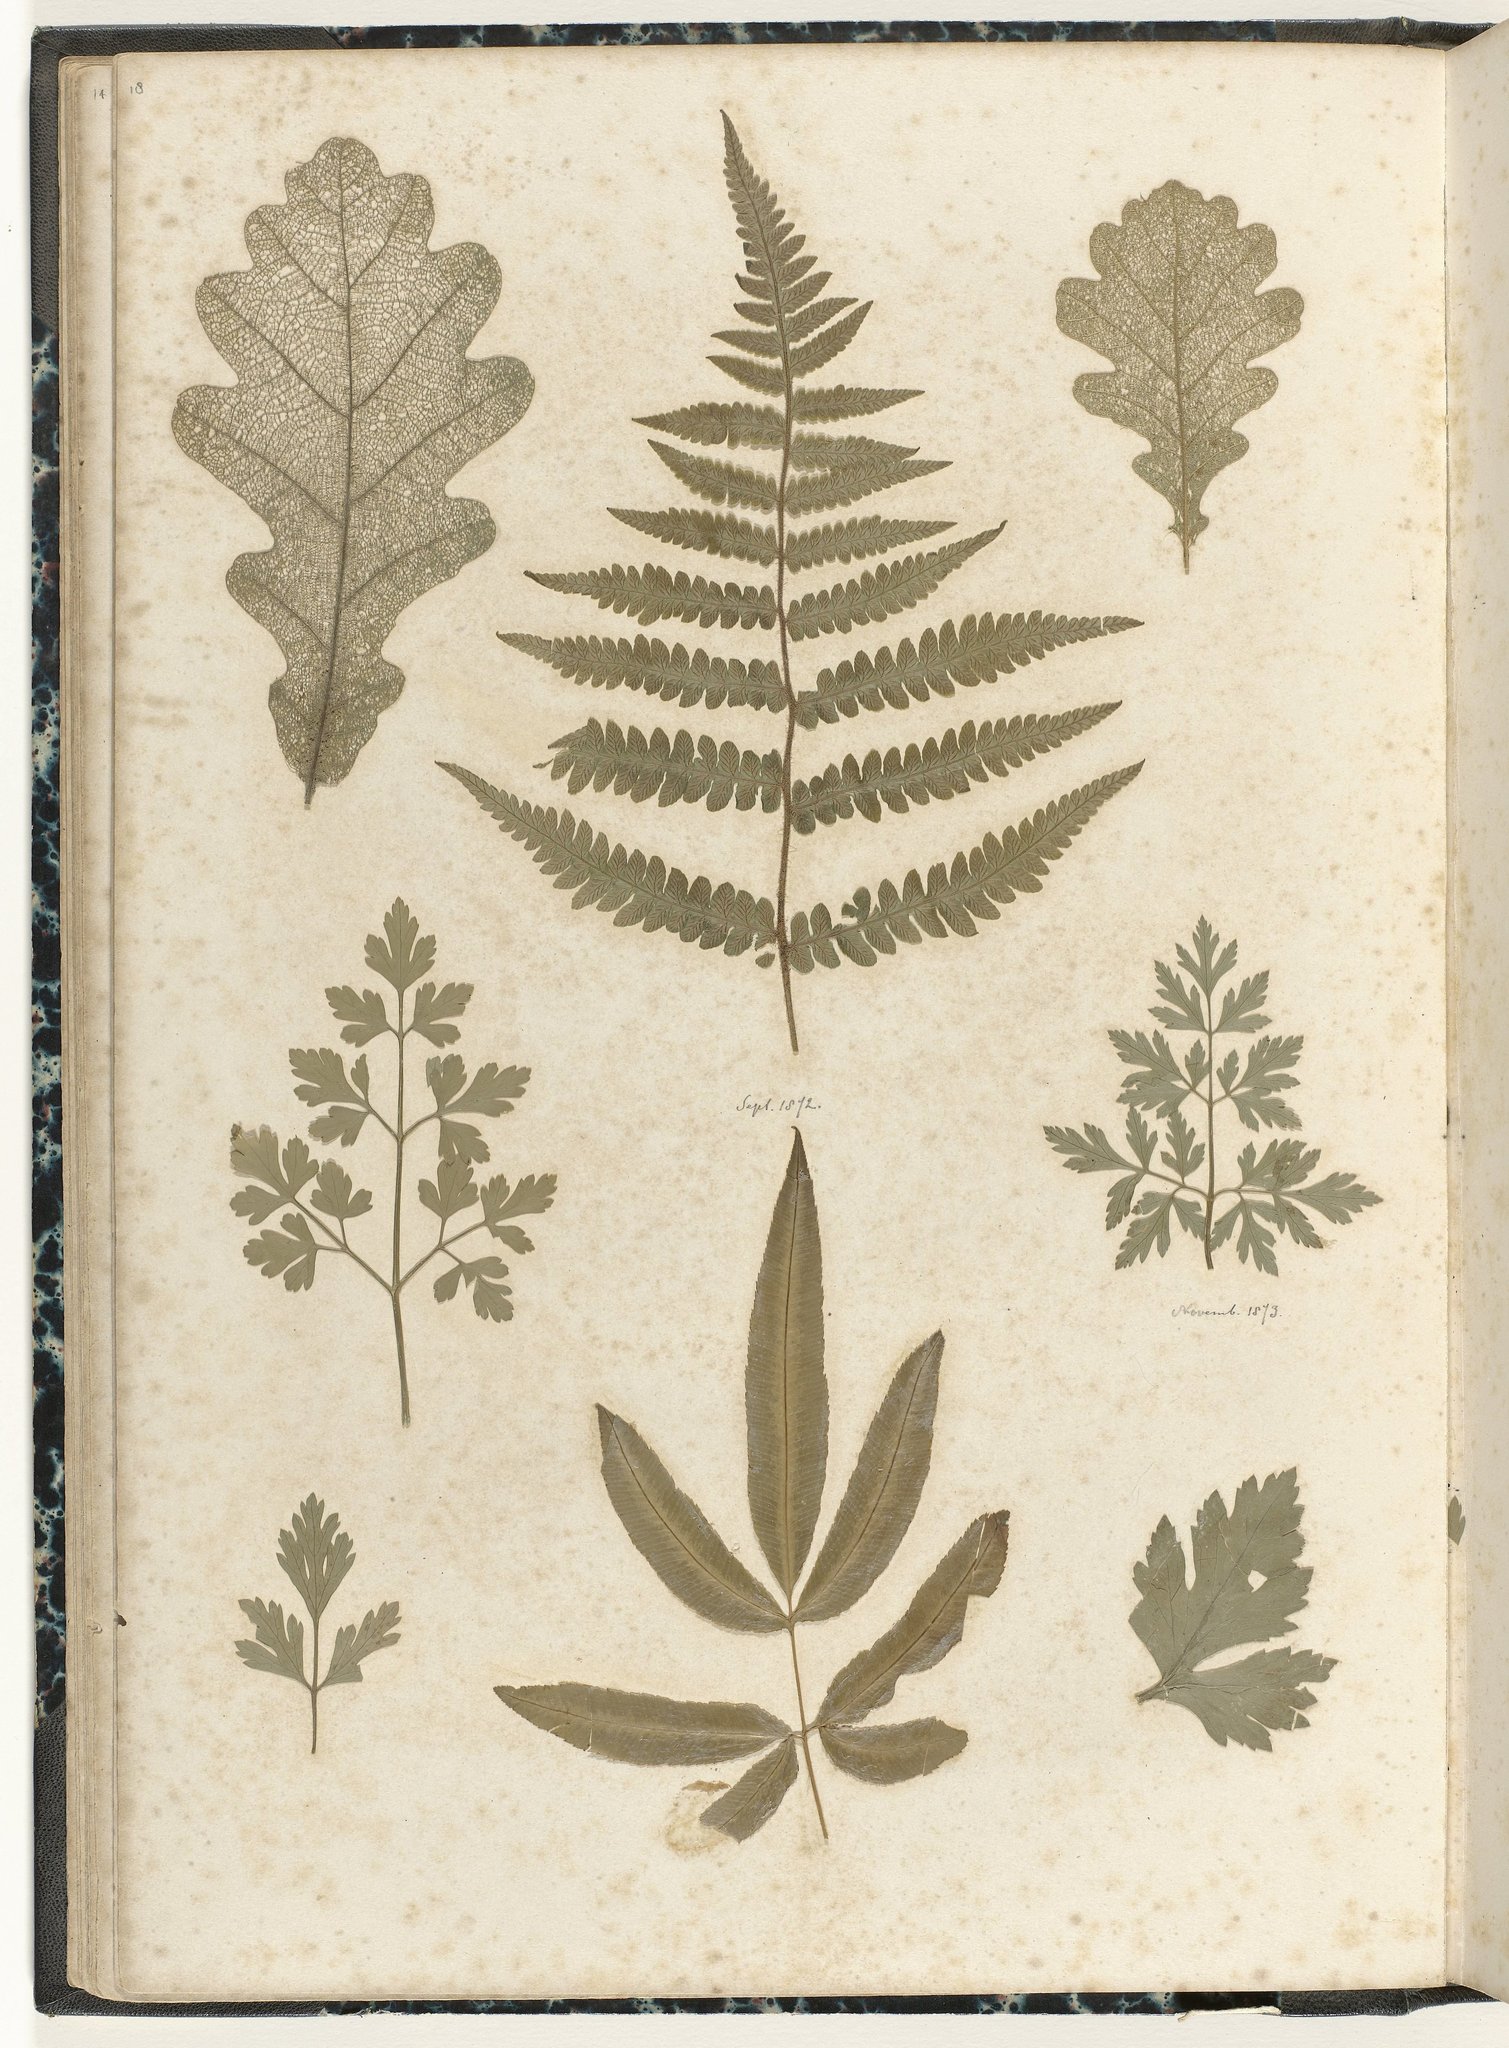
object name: album leaf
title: Acht bladeren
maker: p.j. kool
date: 1872-1873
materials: leaf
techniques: printmaking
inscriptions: annotation: ‘Novemb. 1873.’, annotation: ‘Sept. 1872.’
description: Opgeplakte bladeren waaronder twee eikenbladeren en een varenblad.